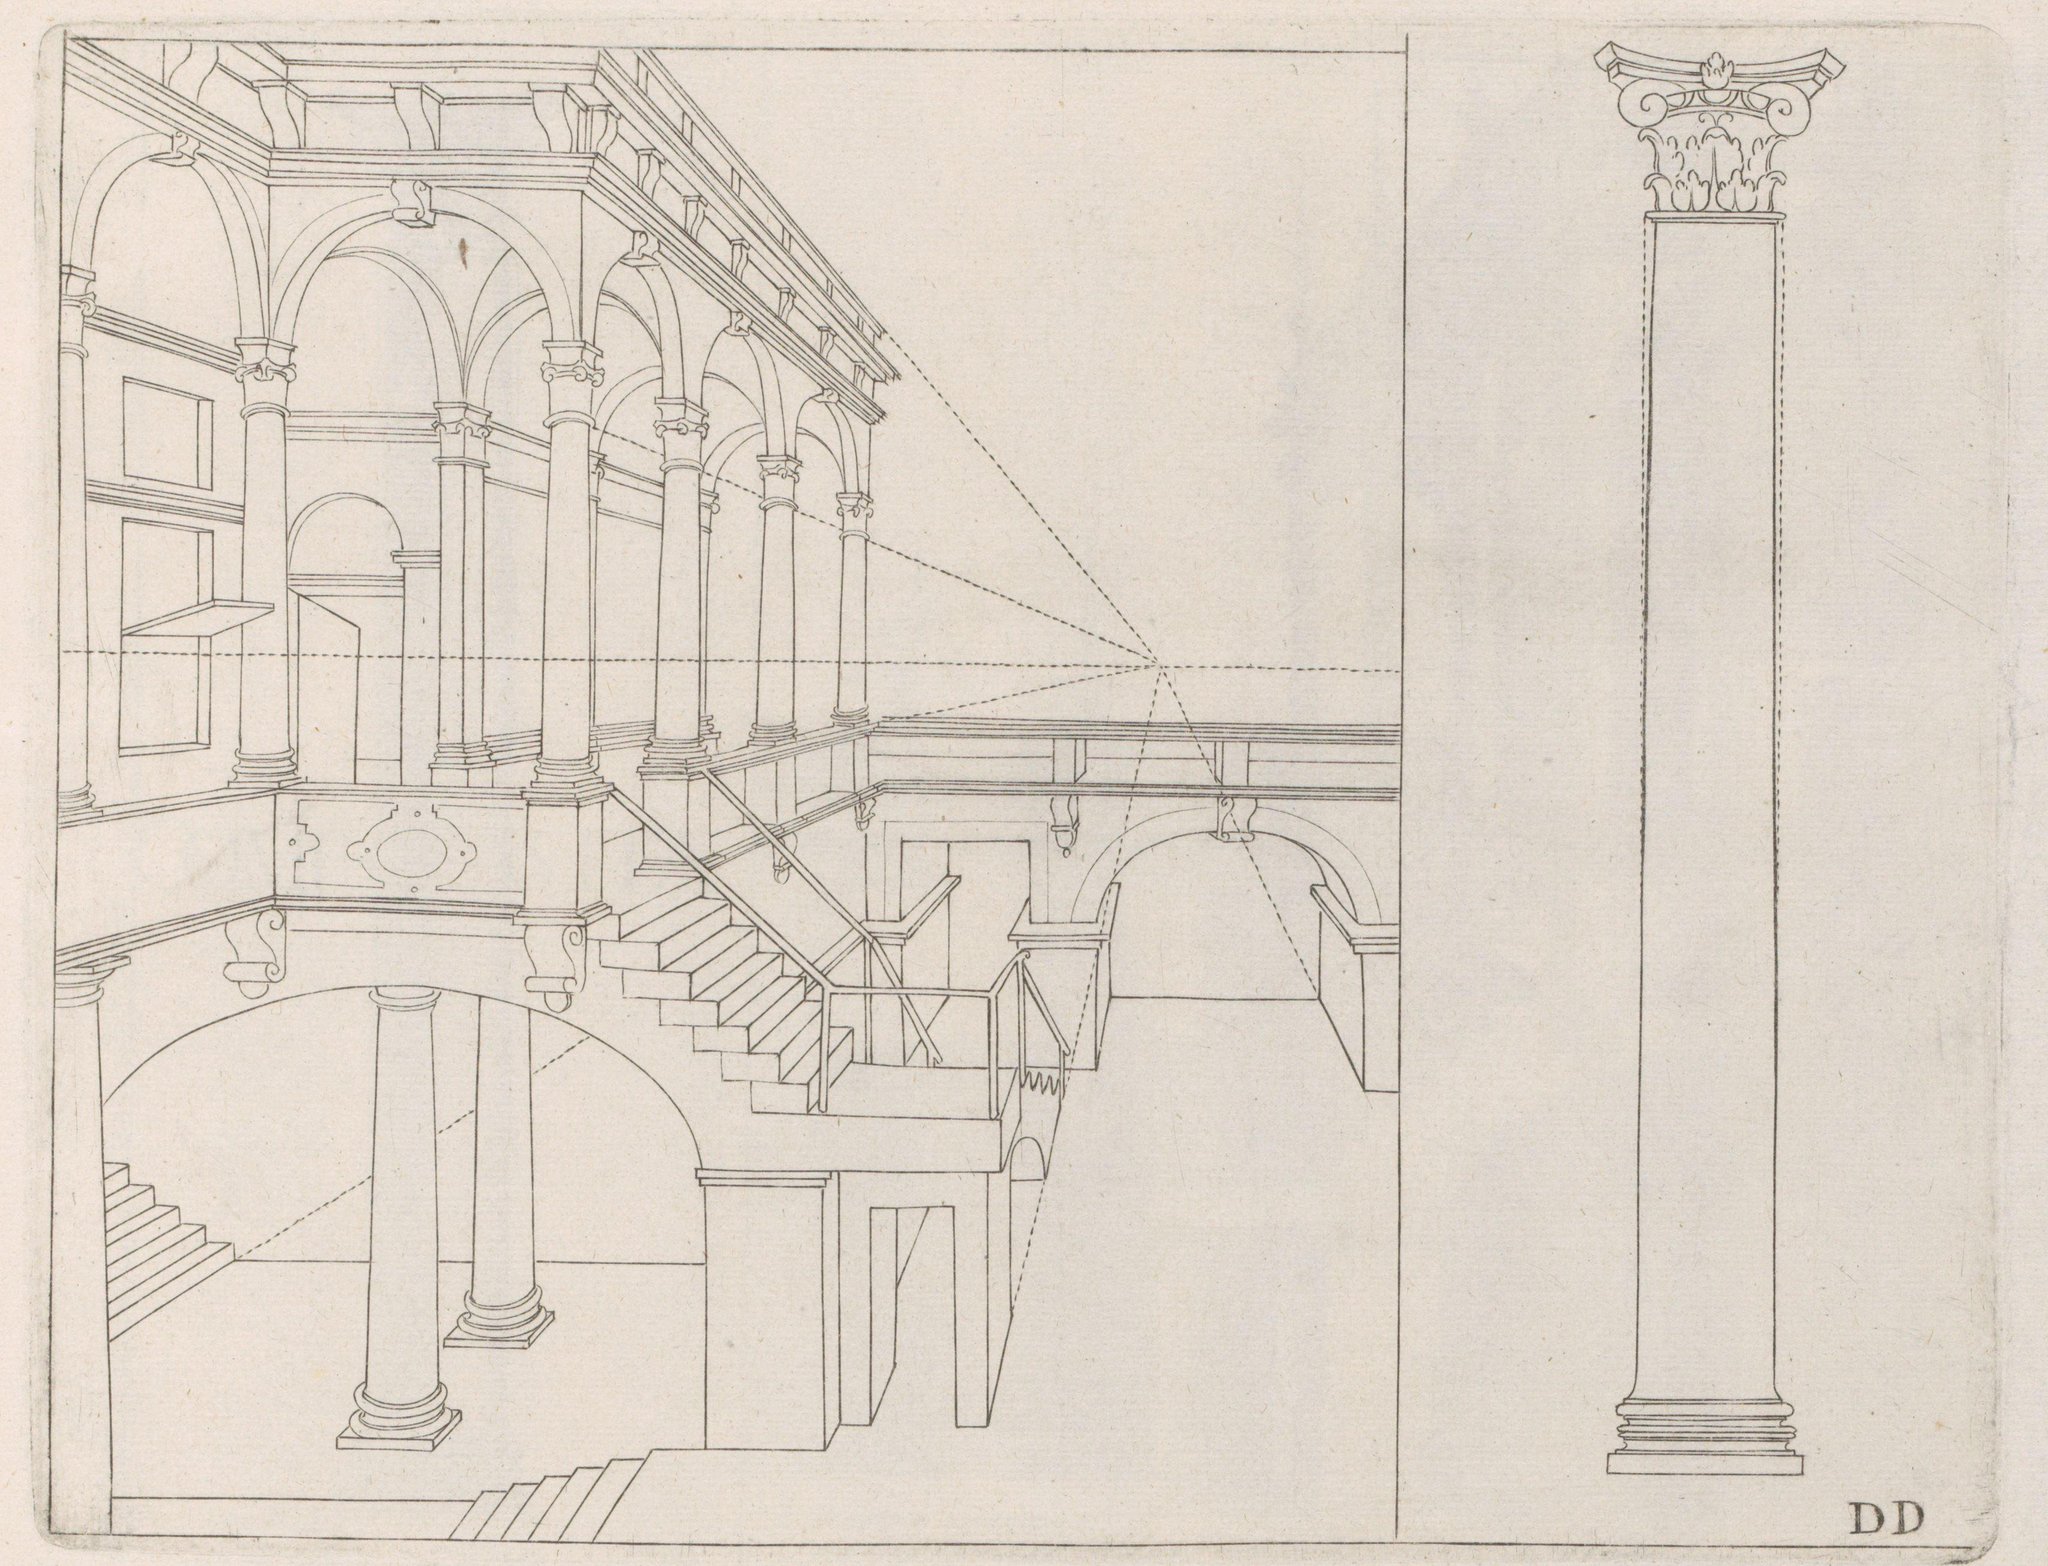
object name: album leaf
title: Architectura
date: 1606-1607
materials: paper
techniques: engraving, etching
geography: amsterdam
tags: composite order ~ architecture, colonnade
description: Gebouw met composiete zuilen en een zuil van de Composiete bouworde. Rechtsonder: DD. Prent maakt deel uit van een album.